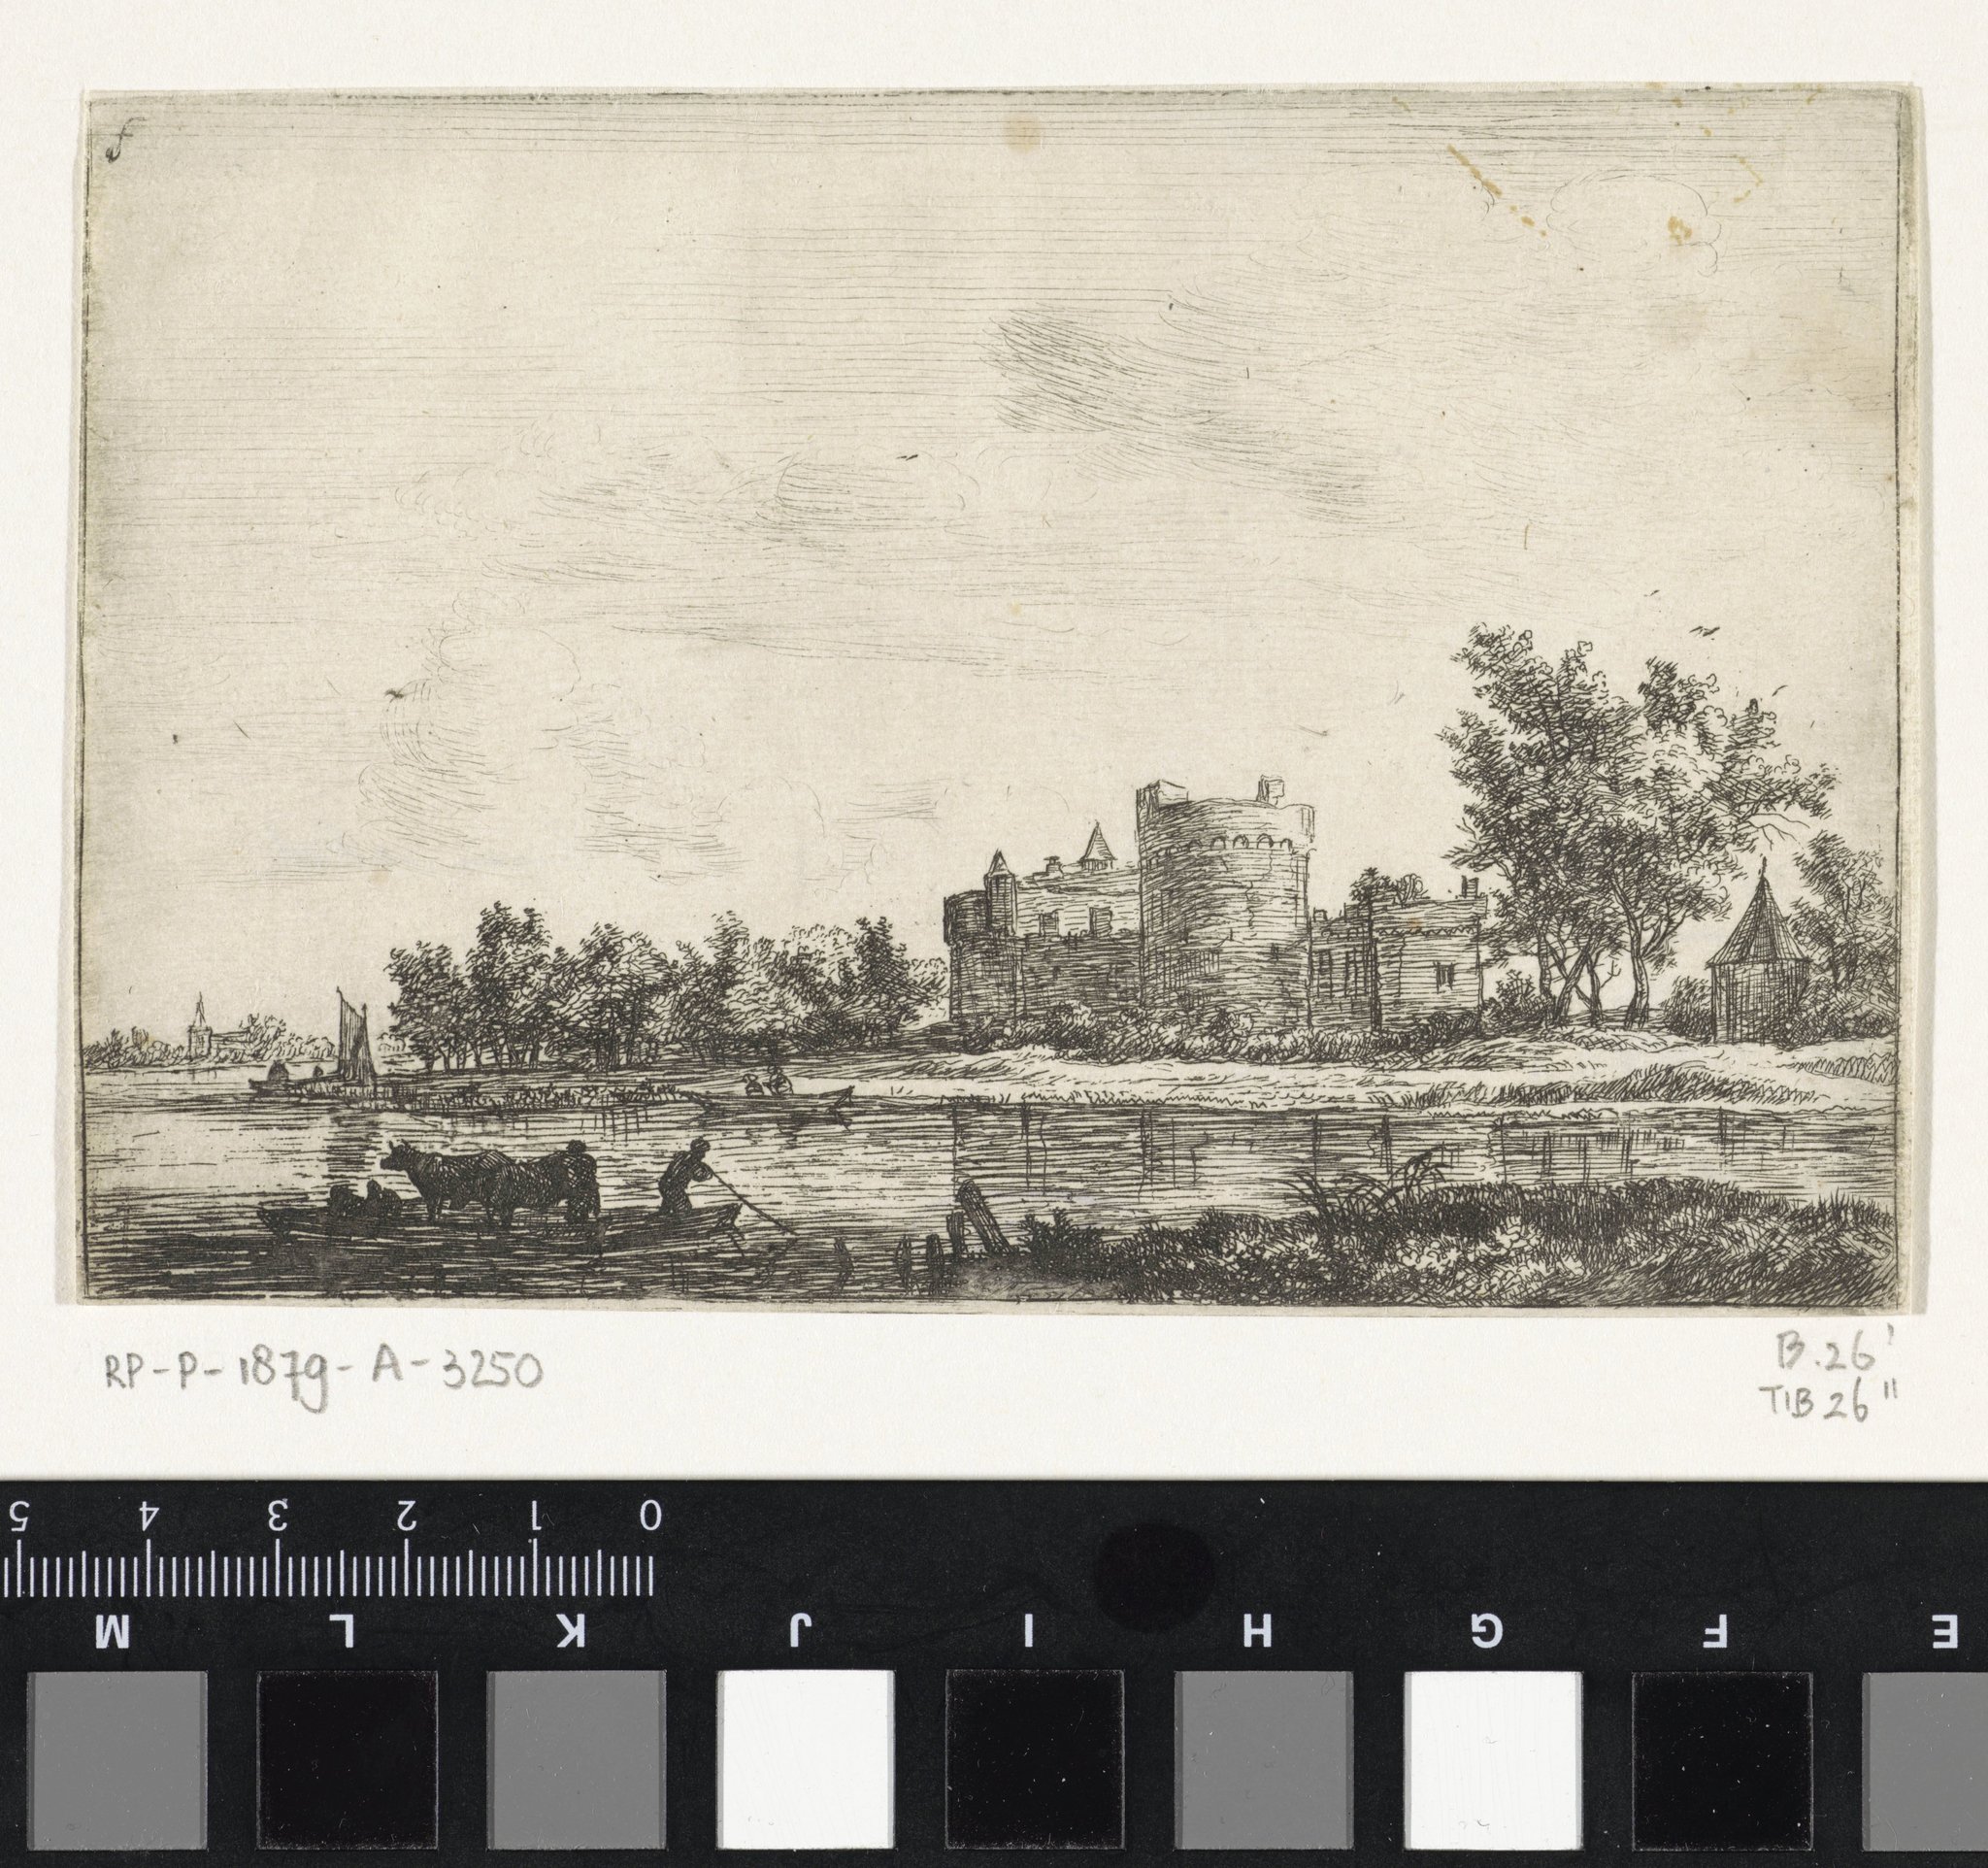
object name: print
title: Burcht aan het water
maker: anthonie waterloo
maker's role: draughtsman, painter, print maker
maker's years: 1609-1690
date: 1630-1663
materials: paper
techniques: etching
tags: cow, landscapes with waters, waterscapes, seascapes (in the temperate zone), rowing-boat, canoe, etc., landscape with tower or castle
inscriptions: collector's mark: Lugt 1209, collector's mark: Lugt 2228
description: Aan het water ligt een burcht met een ronde toren. Vooraan bestuurt een man een roeiboot met figuren en koeien. Linksboven de letter f.